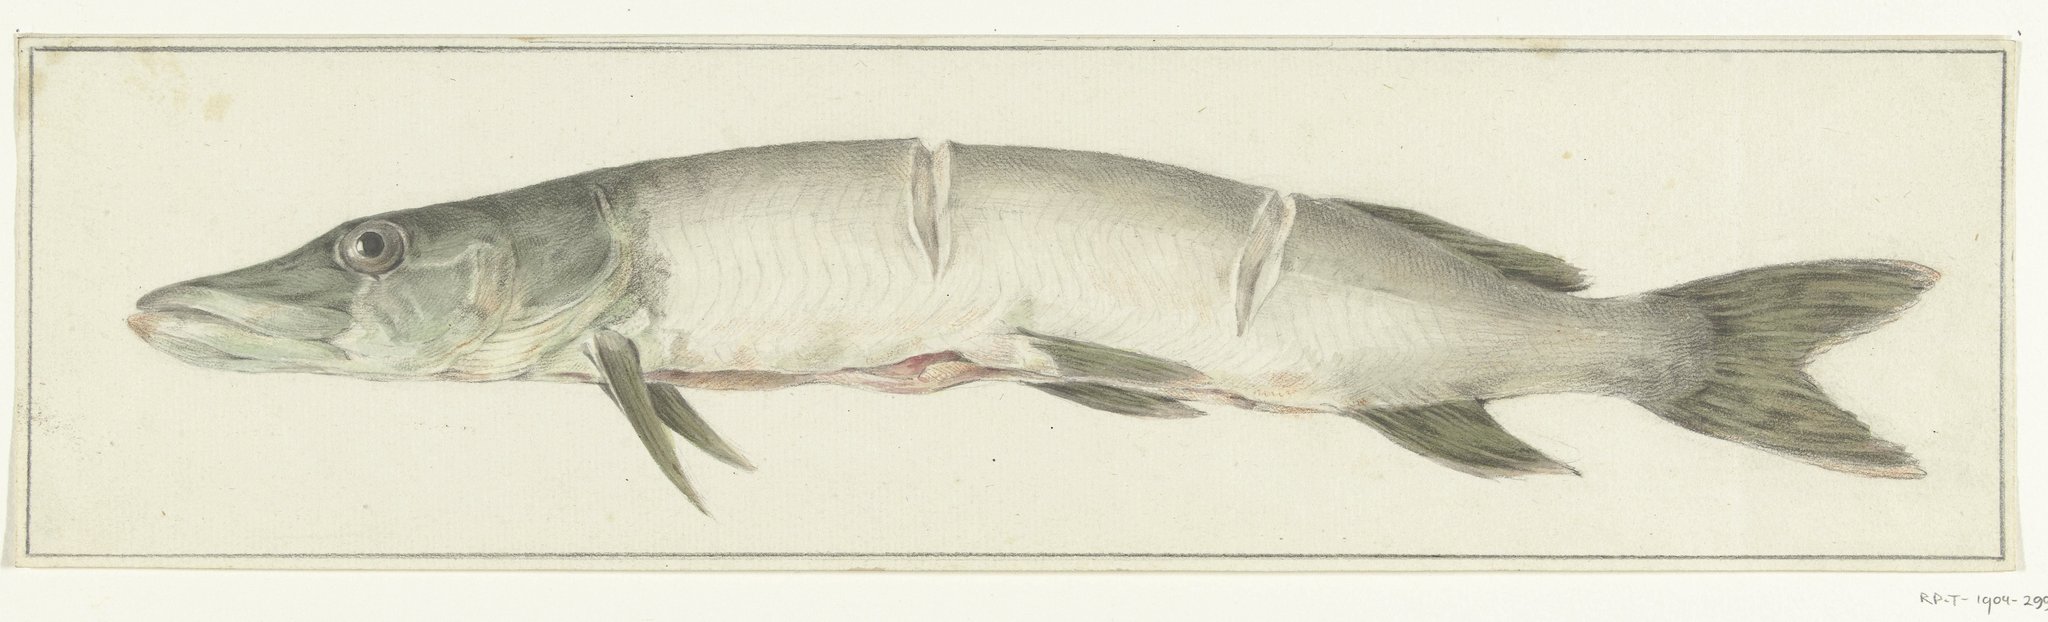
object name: drawing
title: Snoek, met twee inkepingen op de rug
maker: jean bernard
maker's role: draughtsman, print maker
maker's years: 1765-1833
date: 1775-1833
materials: chalk, paper, pencil, watercolor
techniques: brush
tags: bony fishes: pike